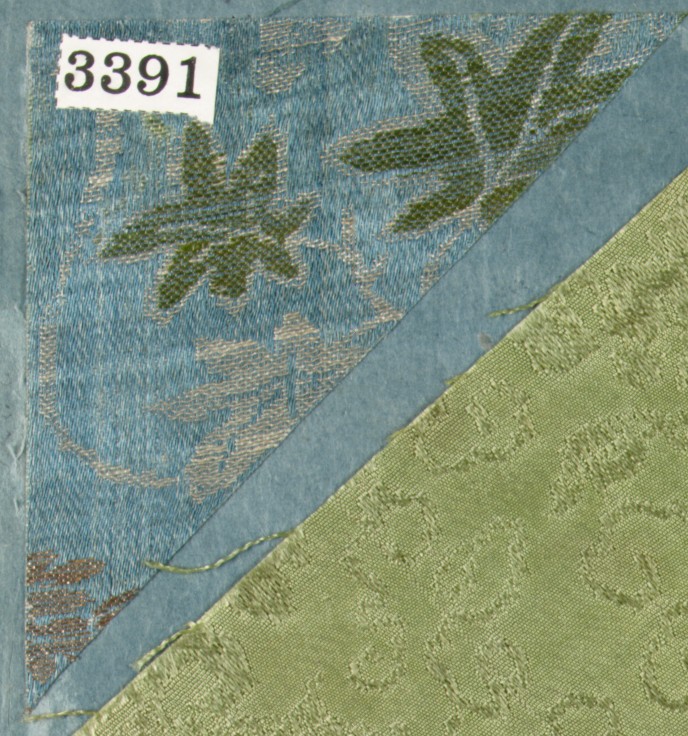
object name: textile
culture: japanese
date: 1801-1900